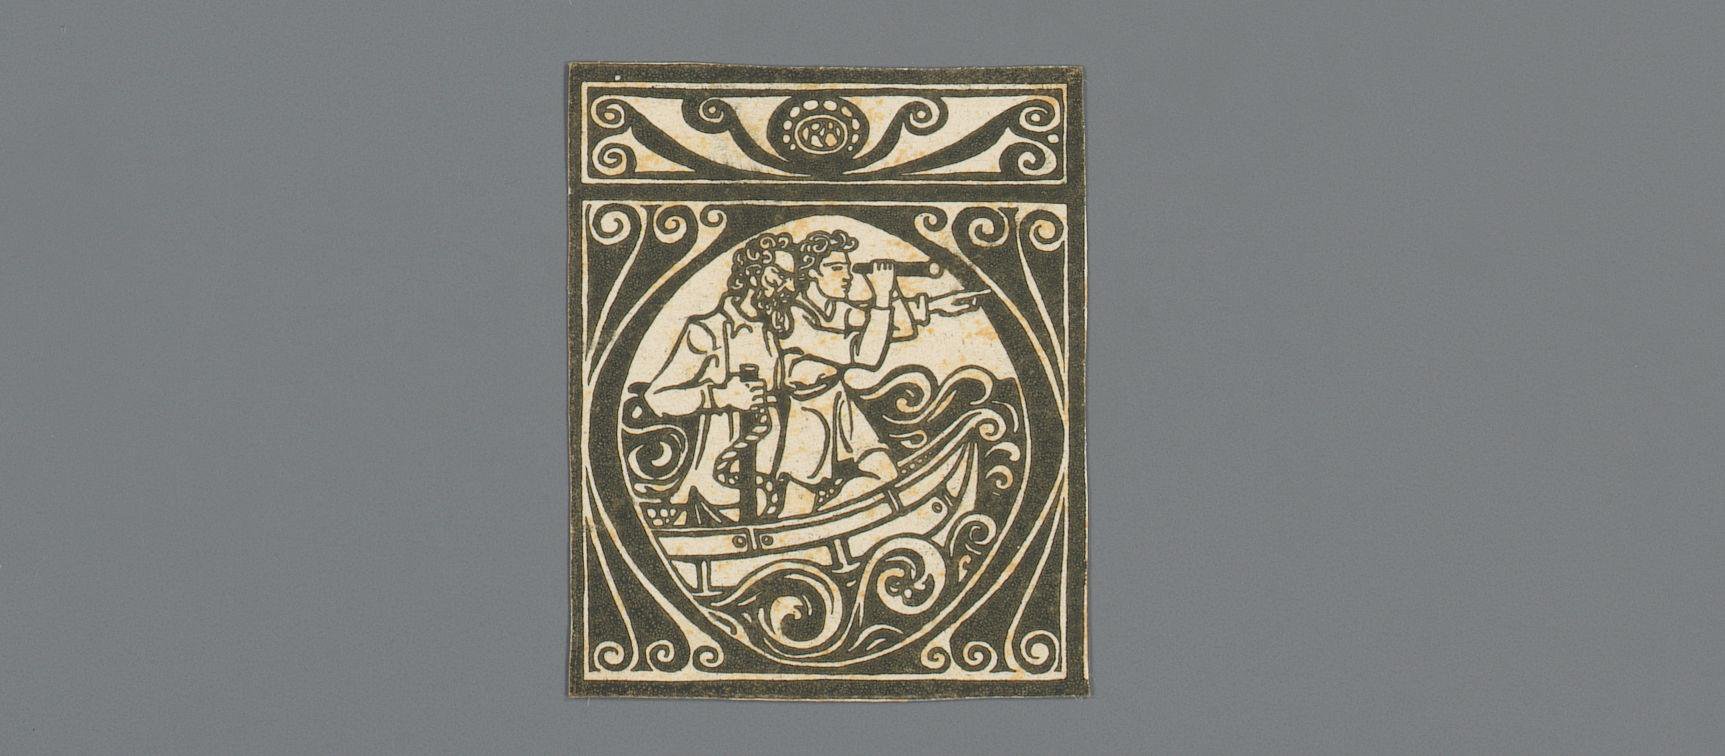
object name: vignette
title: Sluitzegel met vignet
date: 1910-1930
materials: paper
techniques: printing block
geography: netherlands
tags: trade mark, trade token, trade sign, trade card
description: Sluitzegel met een rond vignet met twee mannen uitkijkend vanuit een boot op zee.